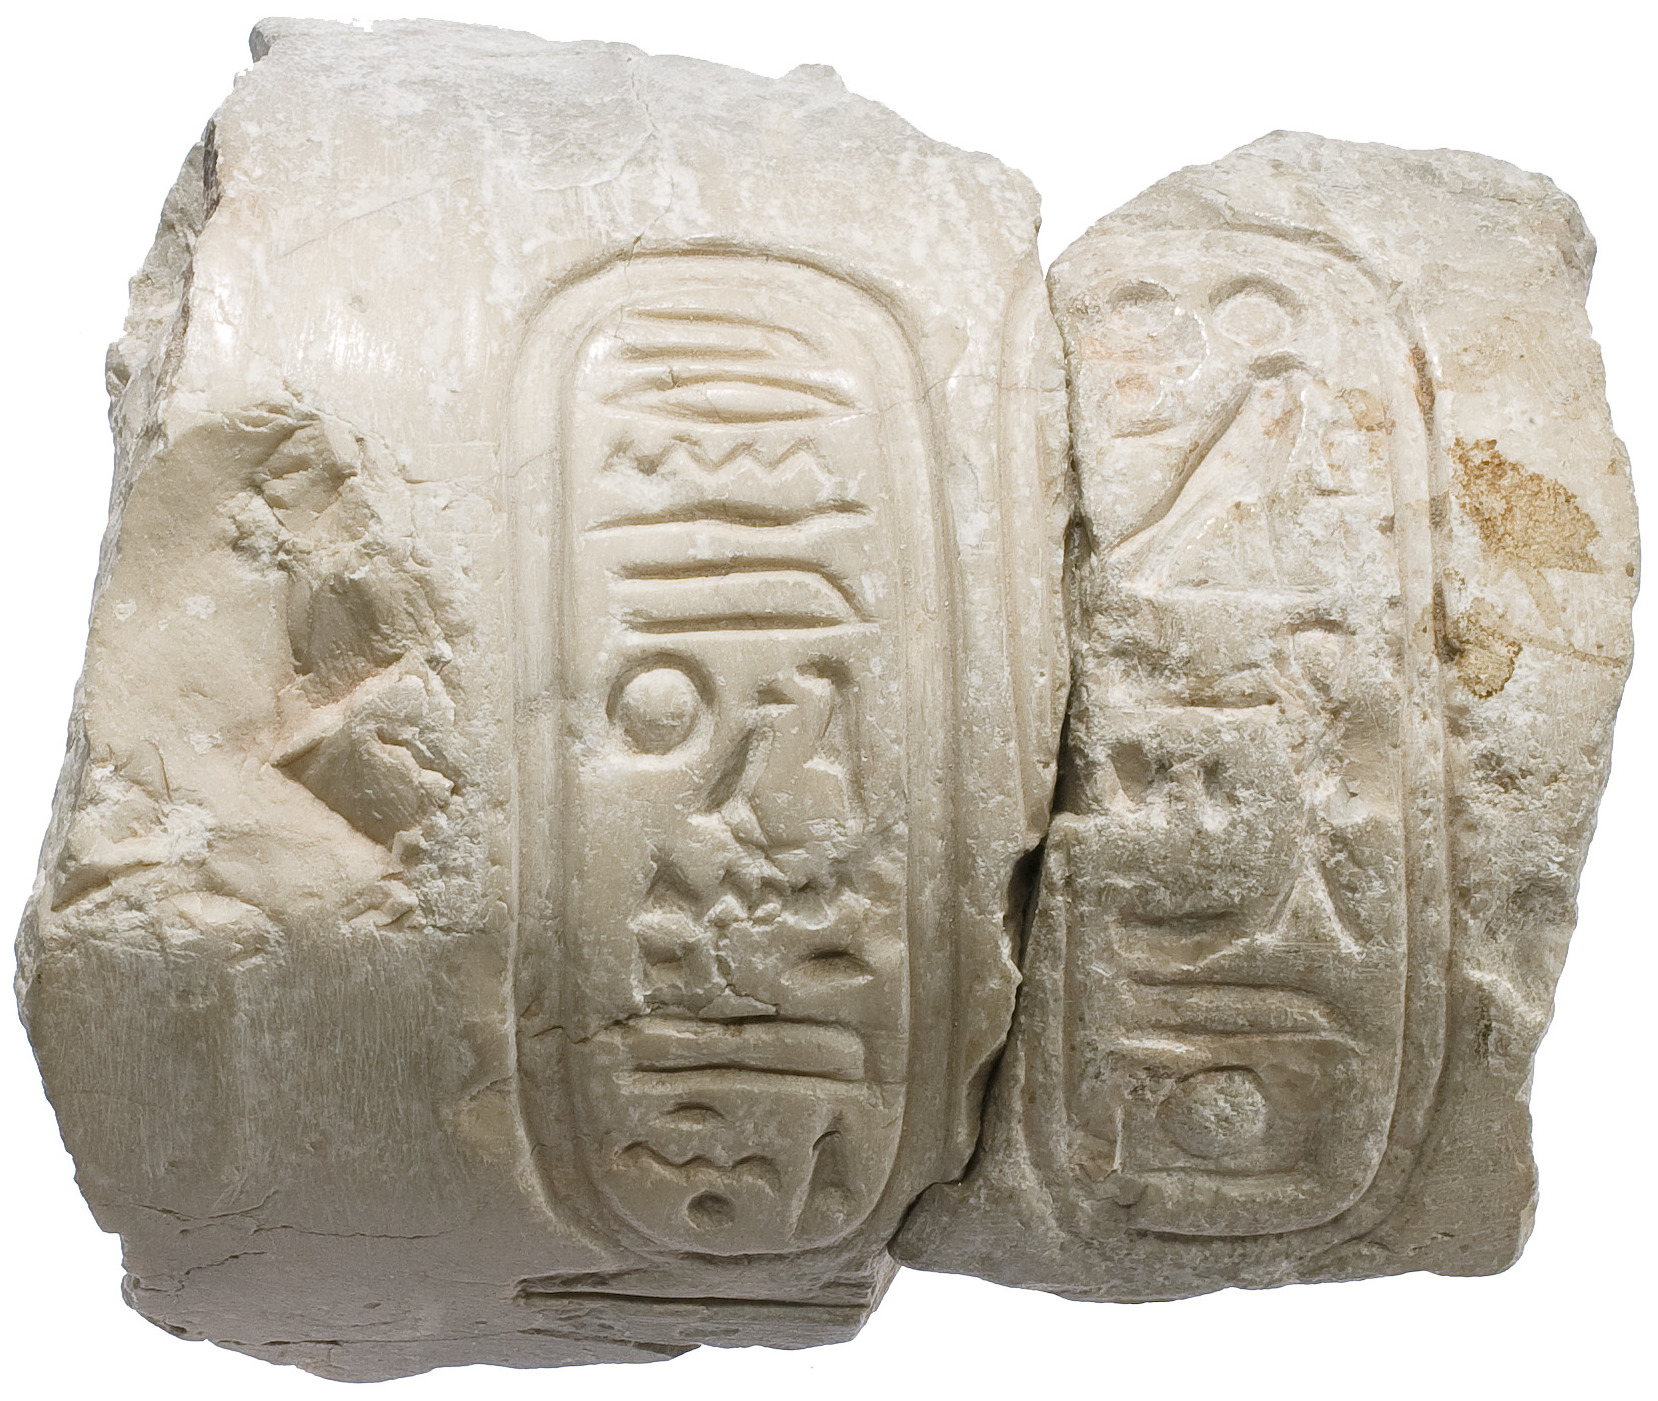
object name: arm, with garment, aten cartouch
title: Forearm with pleated garment, Aten cartouches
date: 1353-1336 BCE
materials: limestone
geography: egypt